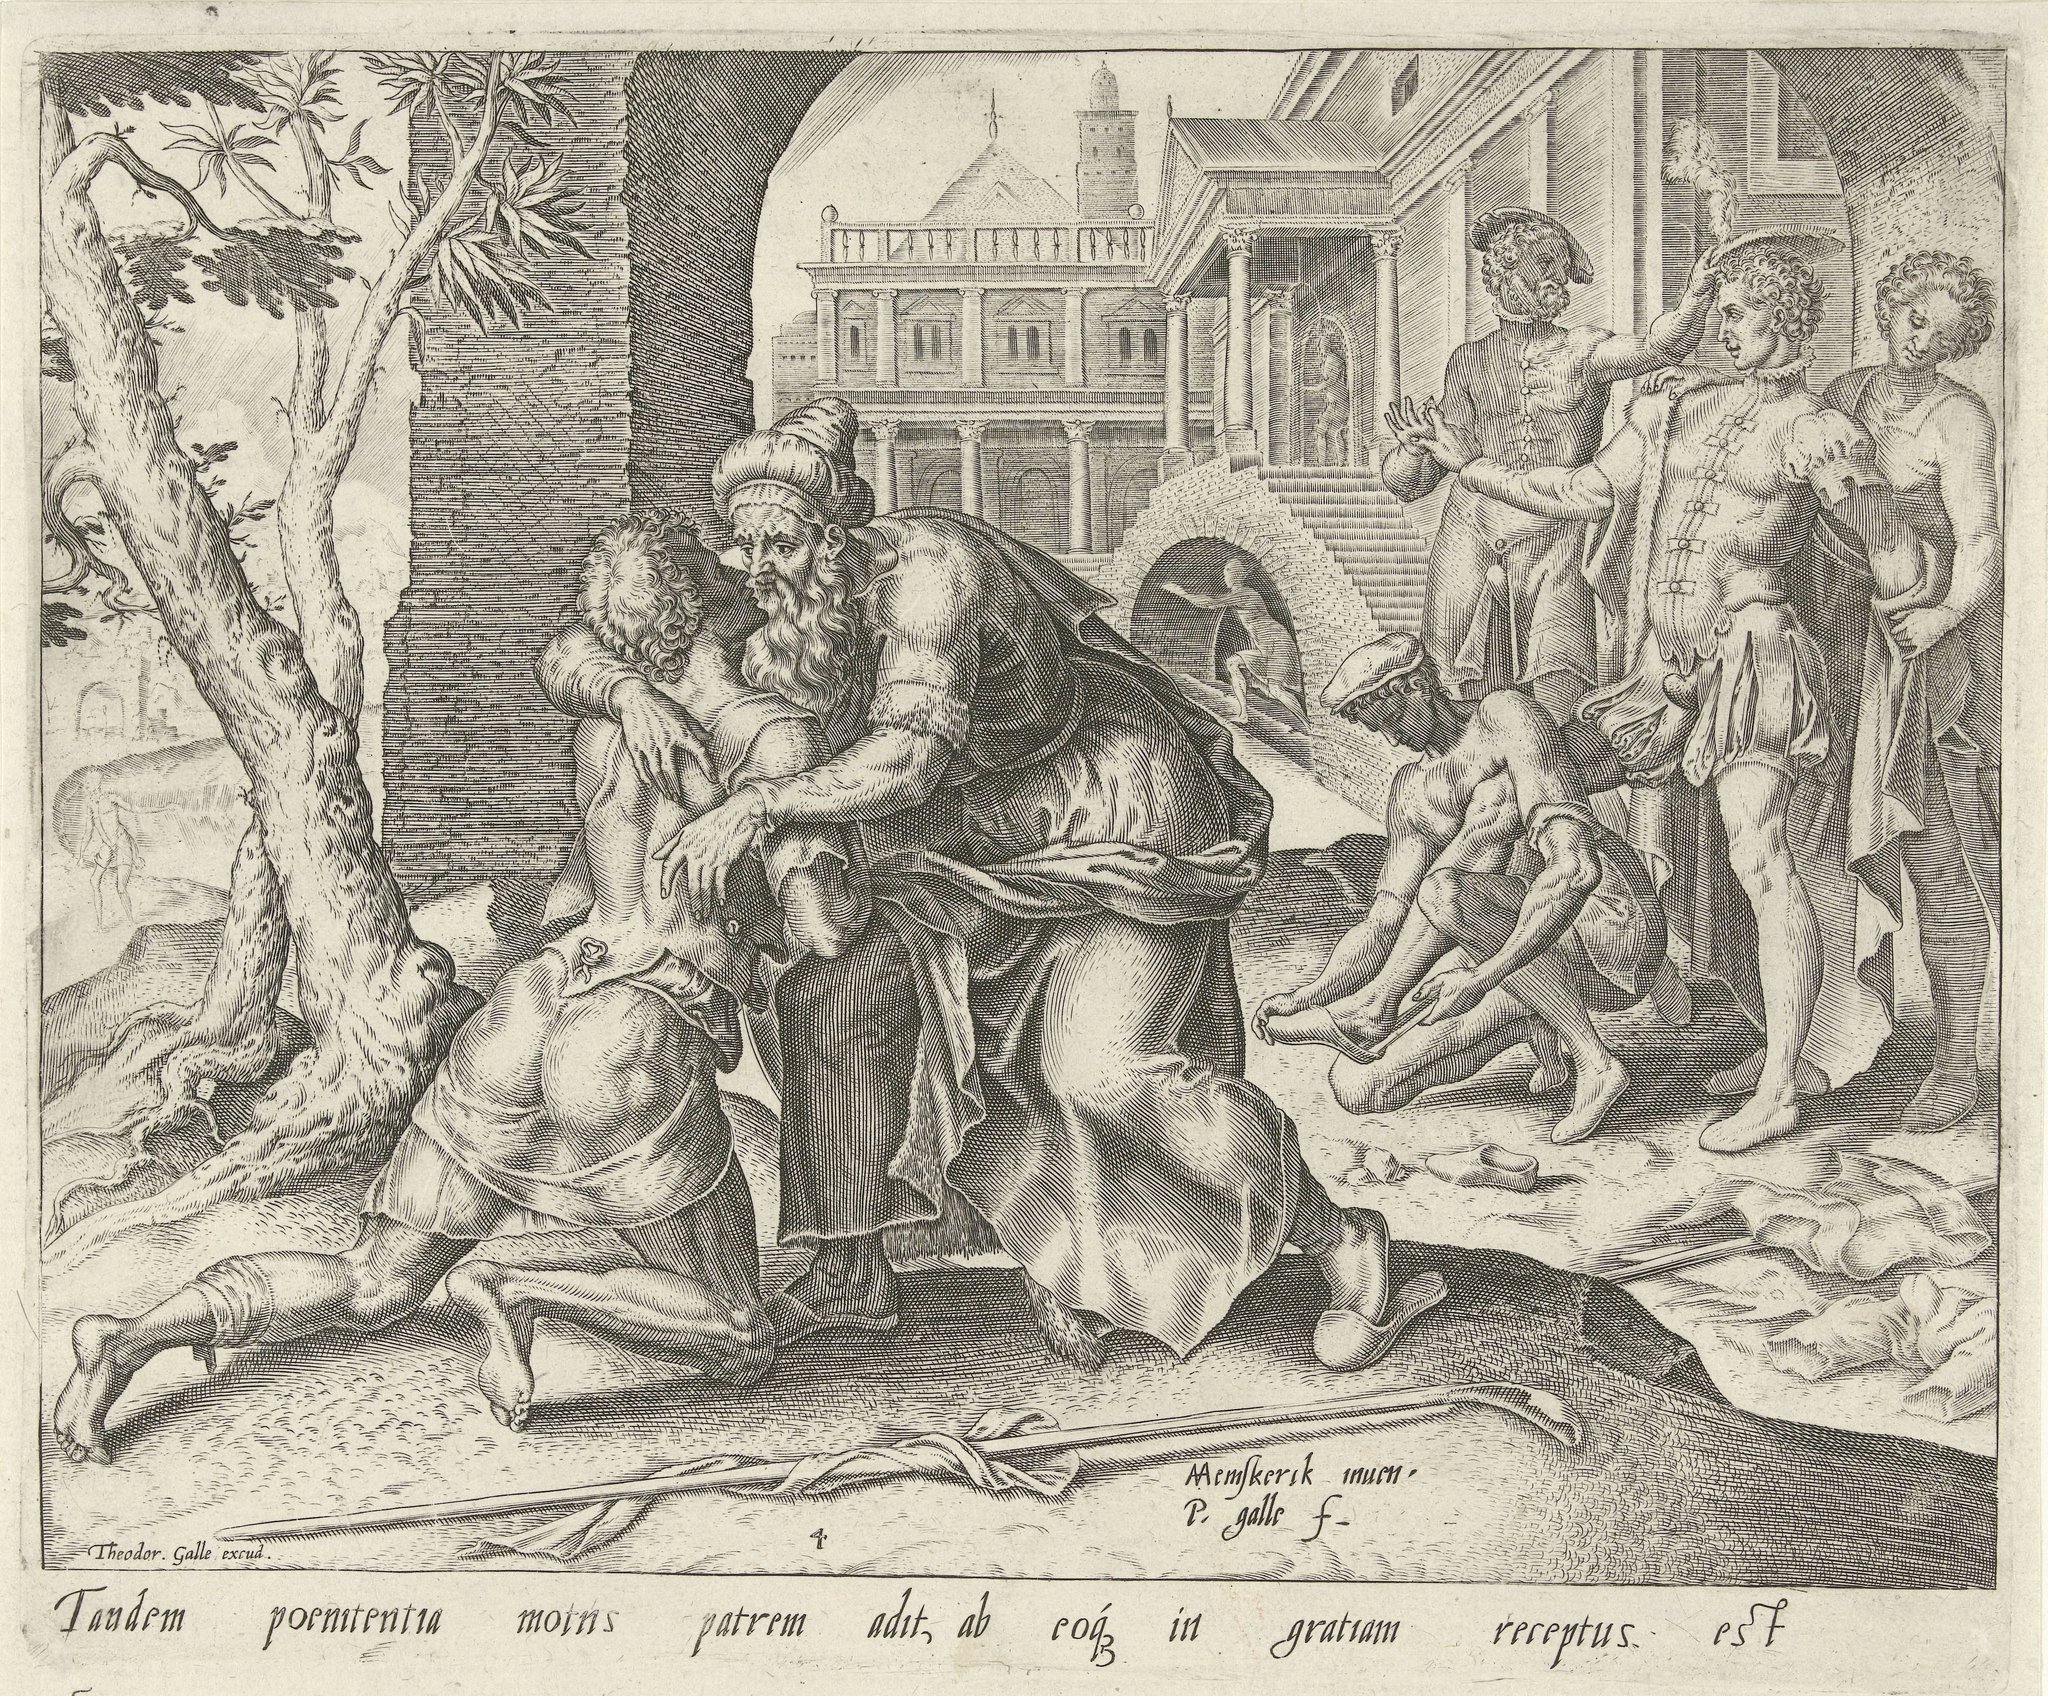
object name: print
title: Gelijkenis van de verloren zoon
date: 1596-1633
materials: paper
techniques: engraving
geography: antwerp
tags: the prodigal son kneels before his father who takes him in his arms, preparations, e.g. the prodigal son is given new robes; slaughtering of the fatted calf; the elder son objects, the parable of the prodigal son (luke 15:11-32)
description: De verloren zoon keert terug naar huis en wordt door zijn vader met open armen ontvangen. Zijn broers helpen hem in schone kleren. De oude varkenshoeder kleren liggen rechts op de grond.